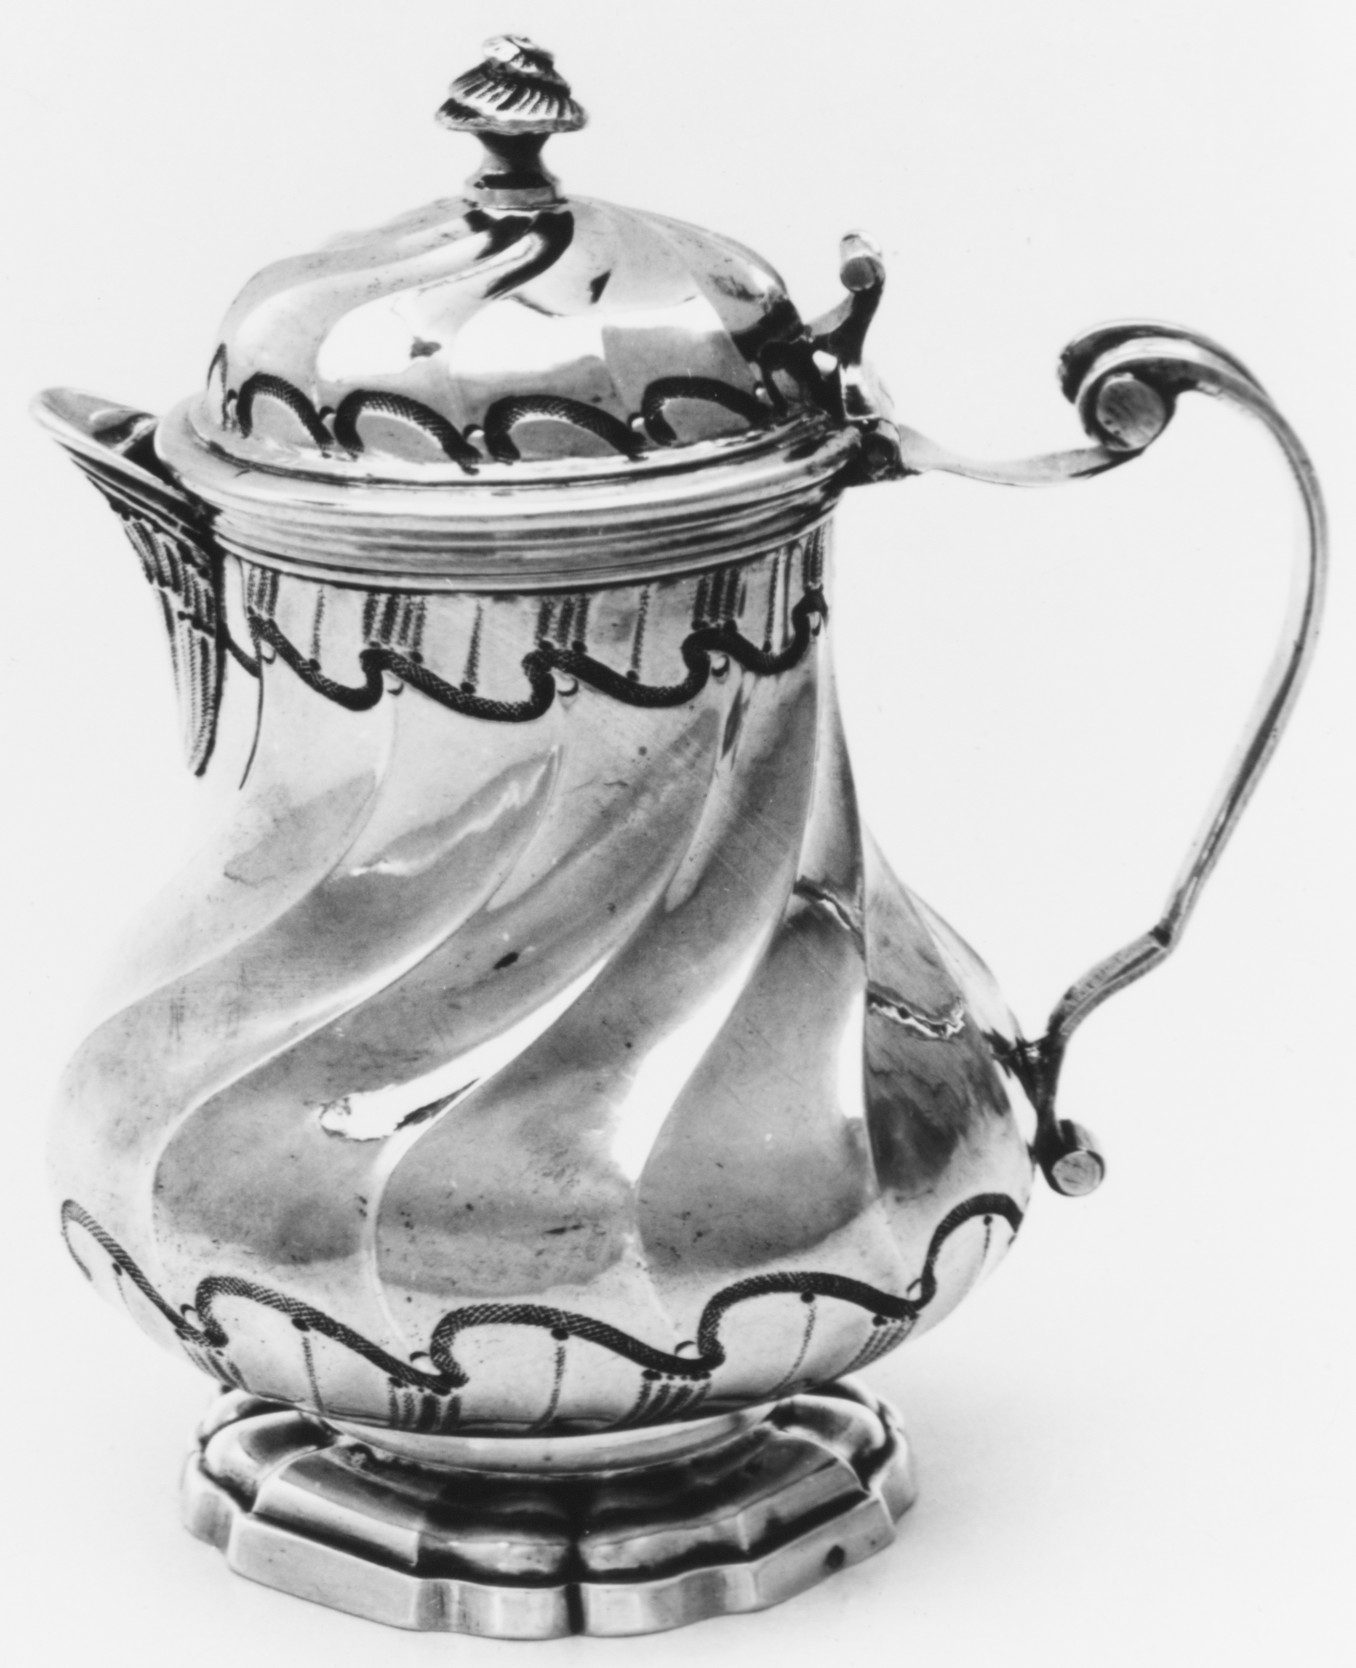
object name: mustard pot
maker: alexis micalef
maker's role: maker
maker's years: 1726-1818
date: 1768-1769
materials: silver